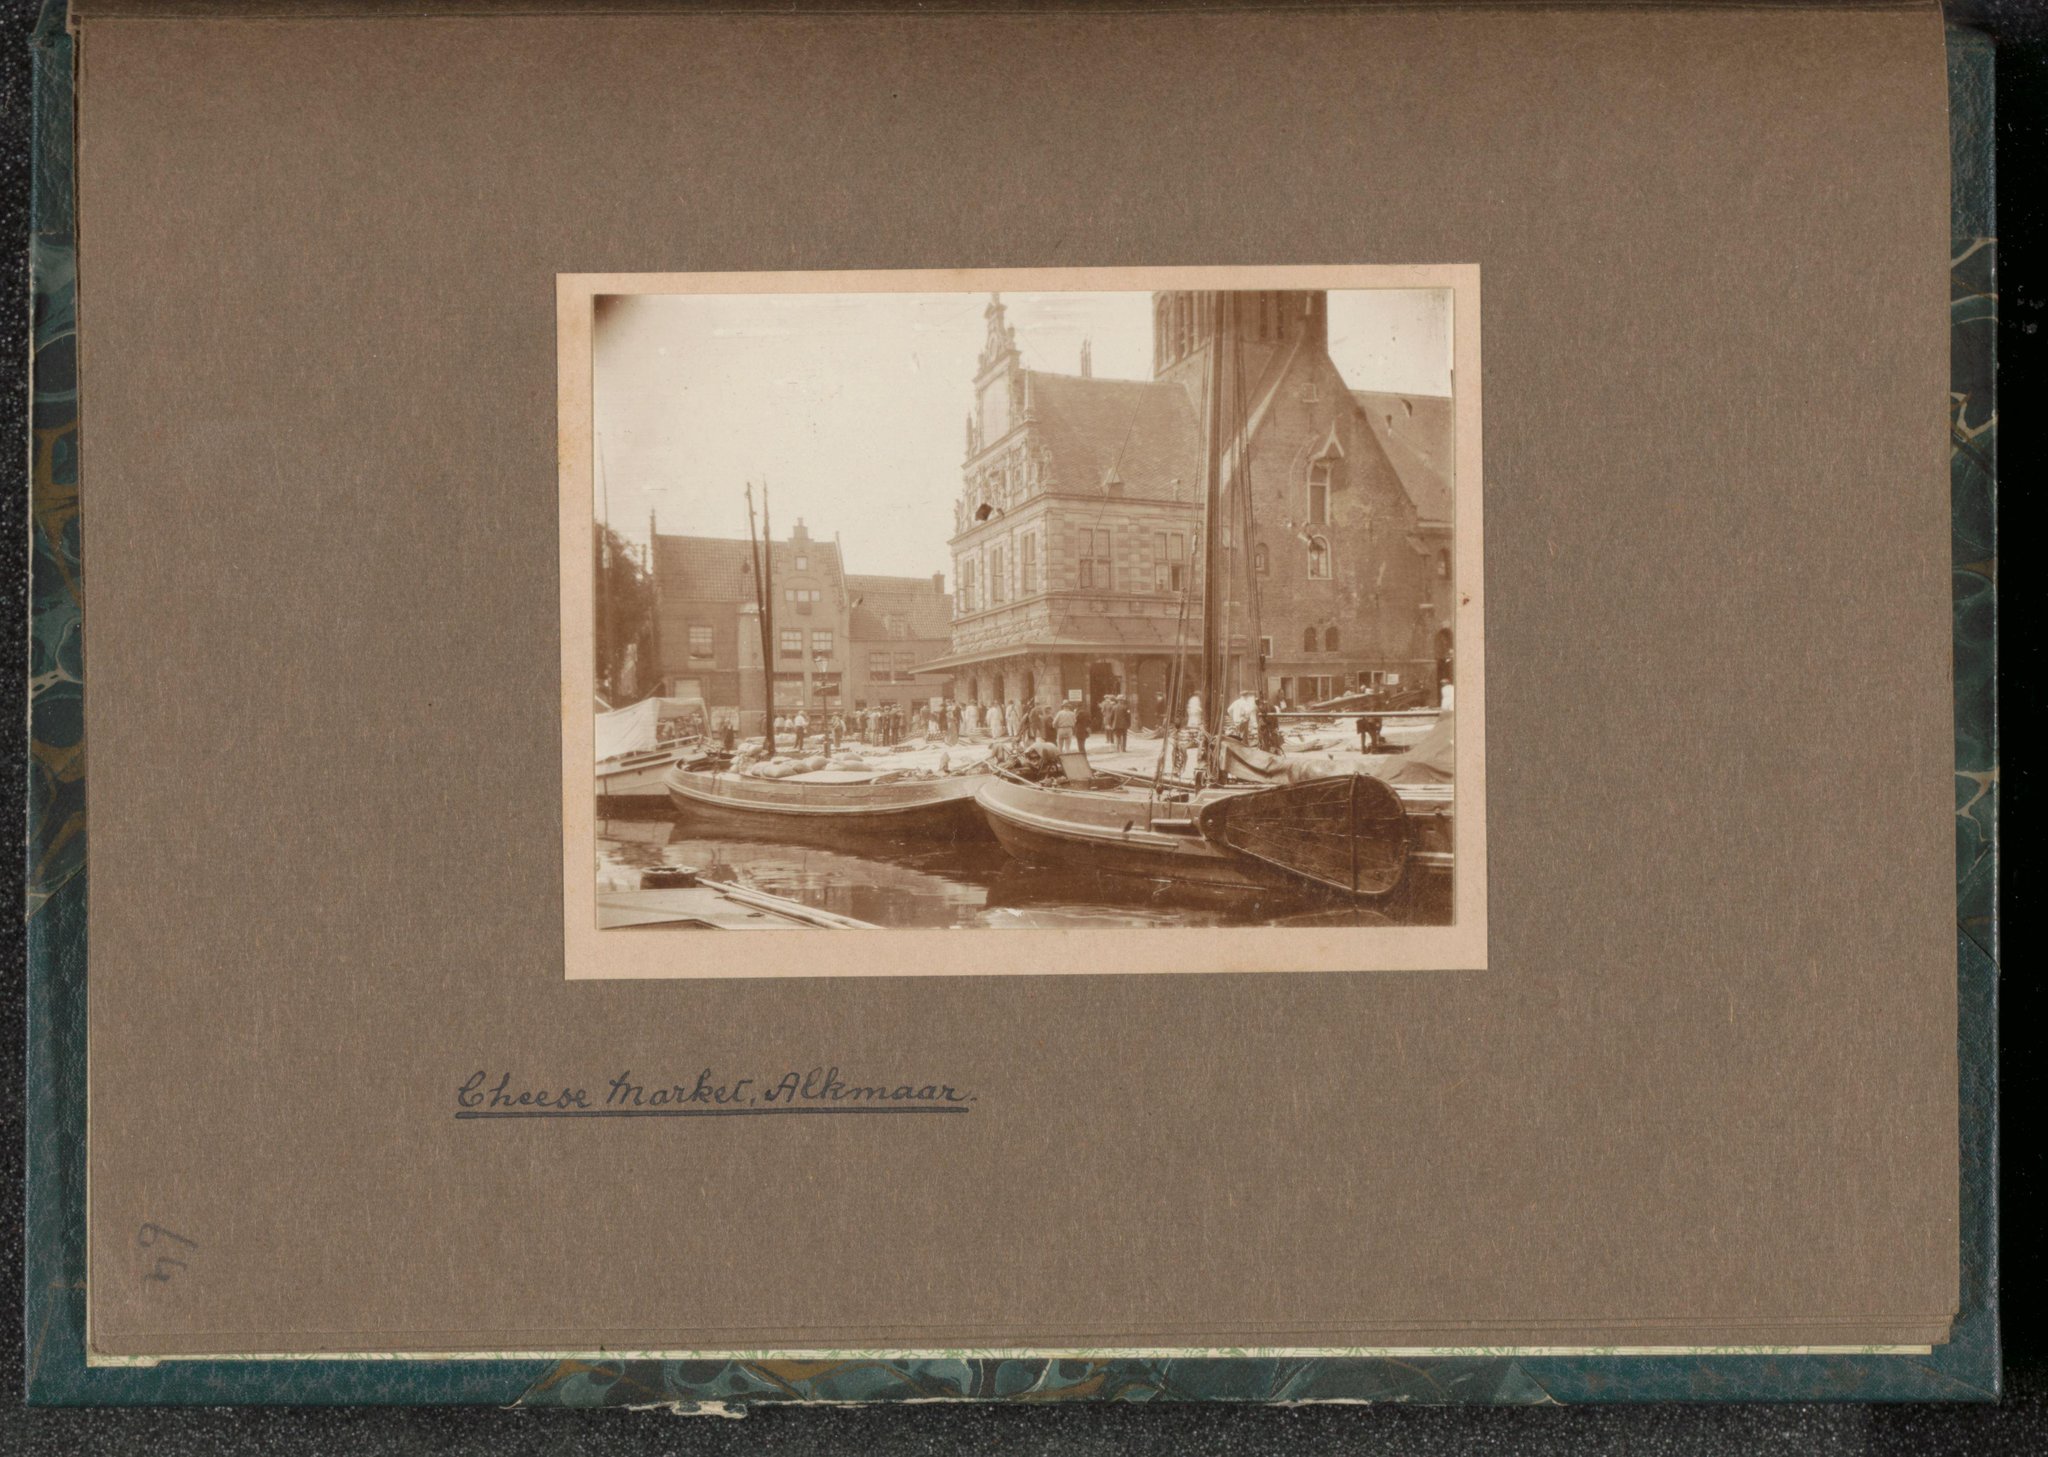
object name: photograph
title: Waaggebouw en huizen aan het Waagplein te Alkmaar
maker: Anonymous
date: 1912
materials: photographic support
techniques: gelatin silver print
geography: alkmaar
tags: freight vessel, canal, travelling; tourism, weigh-house, square, place, circus, etc. (+ city(-scape) with figures, staffage)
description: Onderdeel van Fotoalbum van de excursie naar Nederland van de Britse amateurfotografenvereniging P.C.U.K.